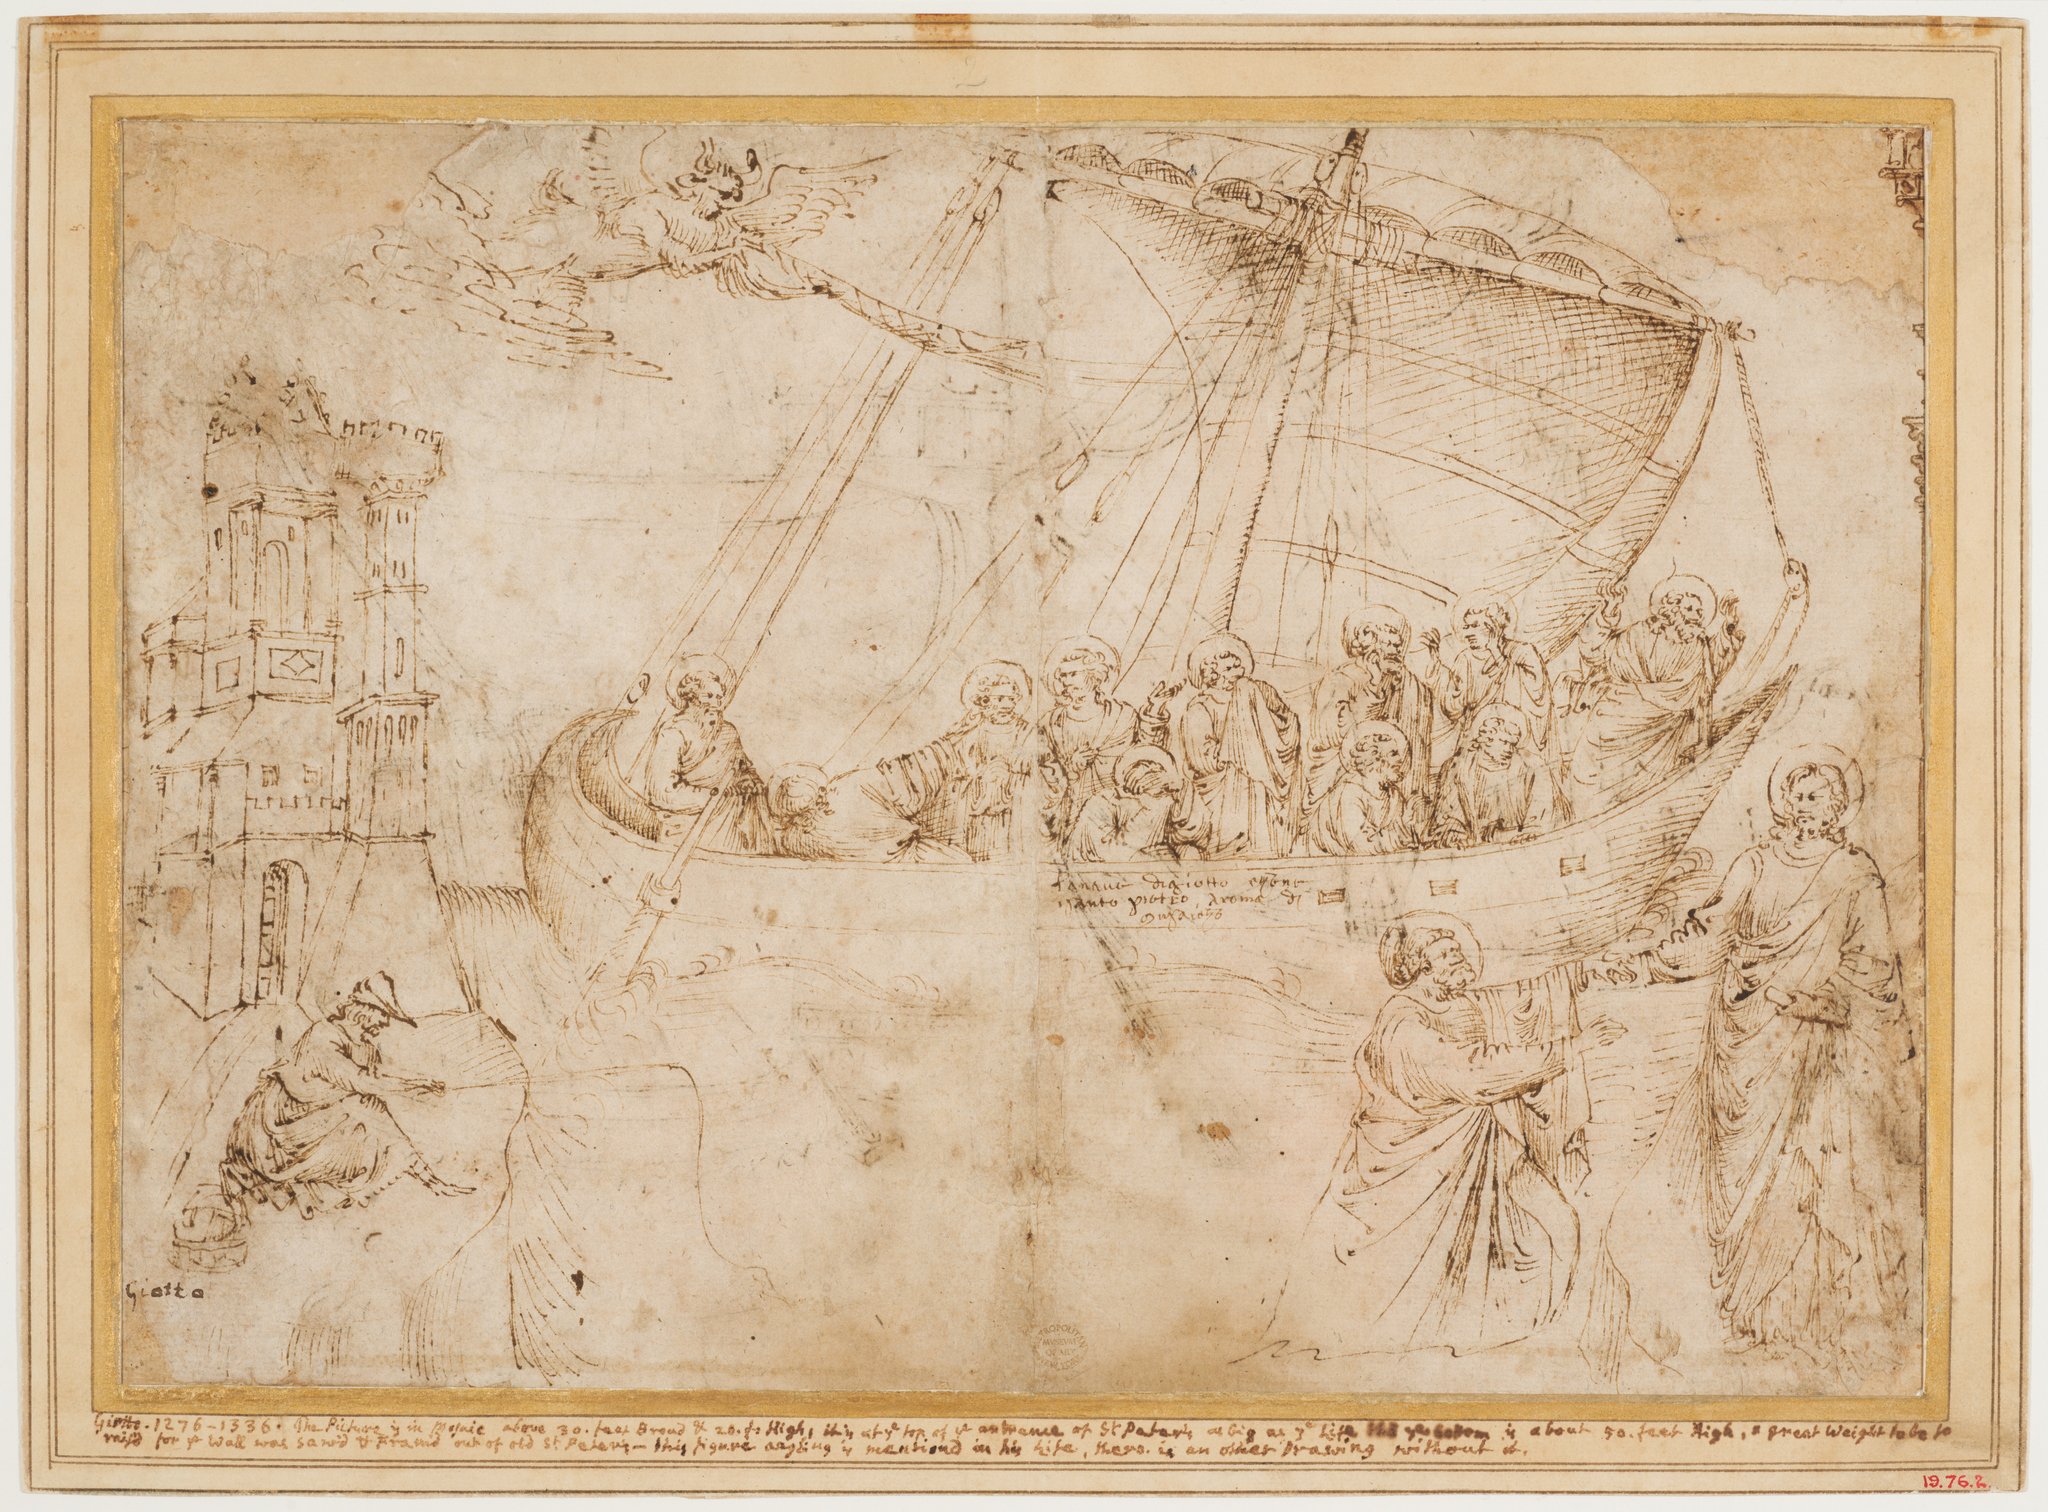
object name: drawing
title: Free Copy of Giotto's "Navicella" (recto); Copy of Adam in Masaccio's "Expulsion from the Garden of Eden", and other Figure Studies (verso)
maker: parri spinelli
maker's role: artist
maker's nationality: italian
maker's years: 1387-1453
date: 1420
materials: chalk, ink, paper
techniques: drawing, pen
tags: men,ships